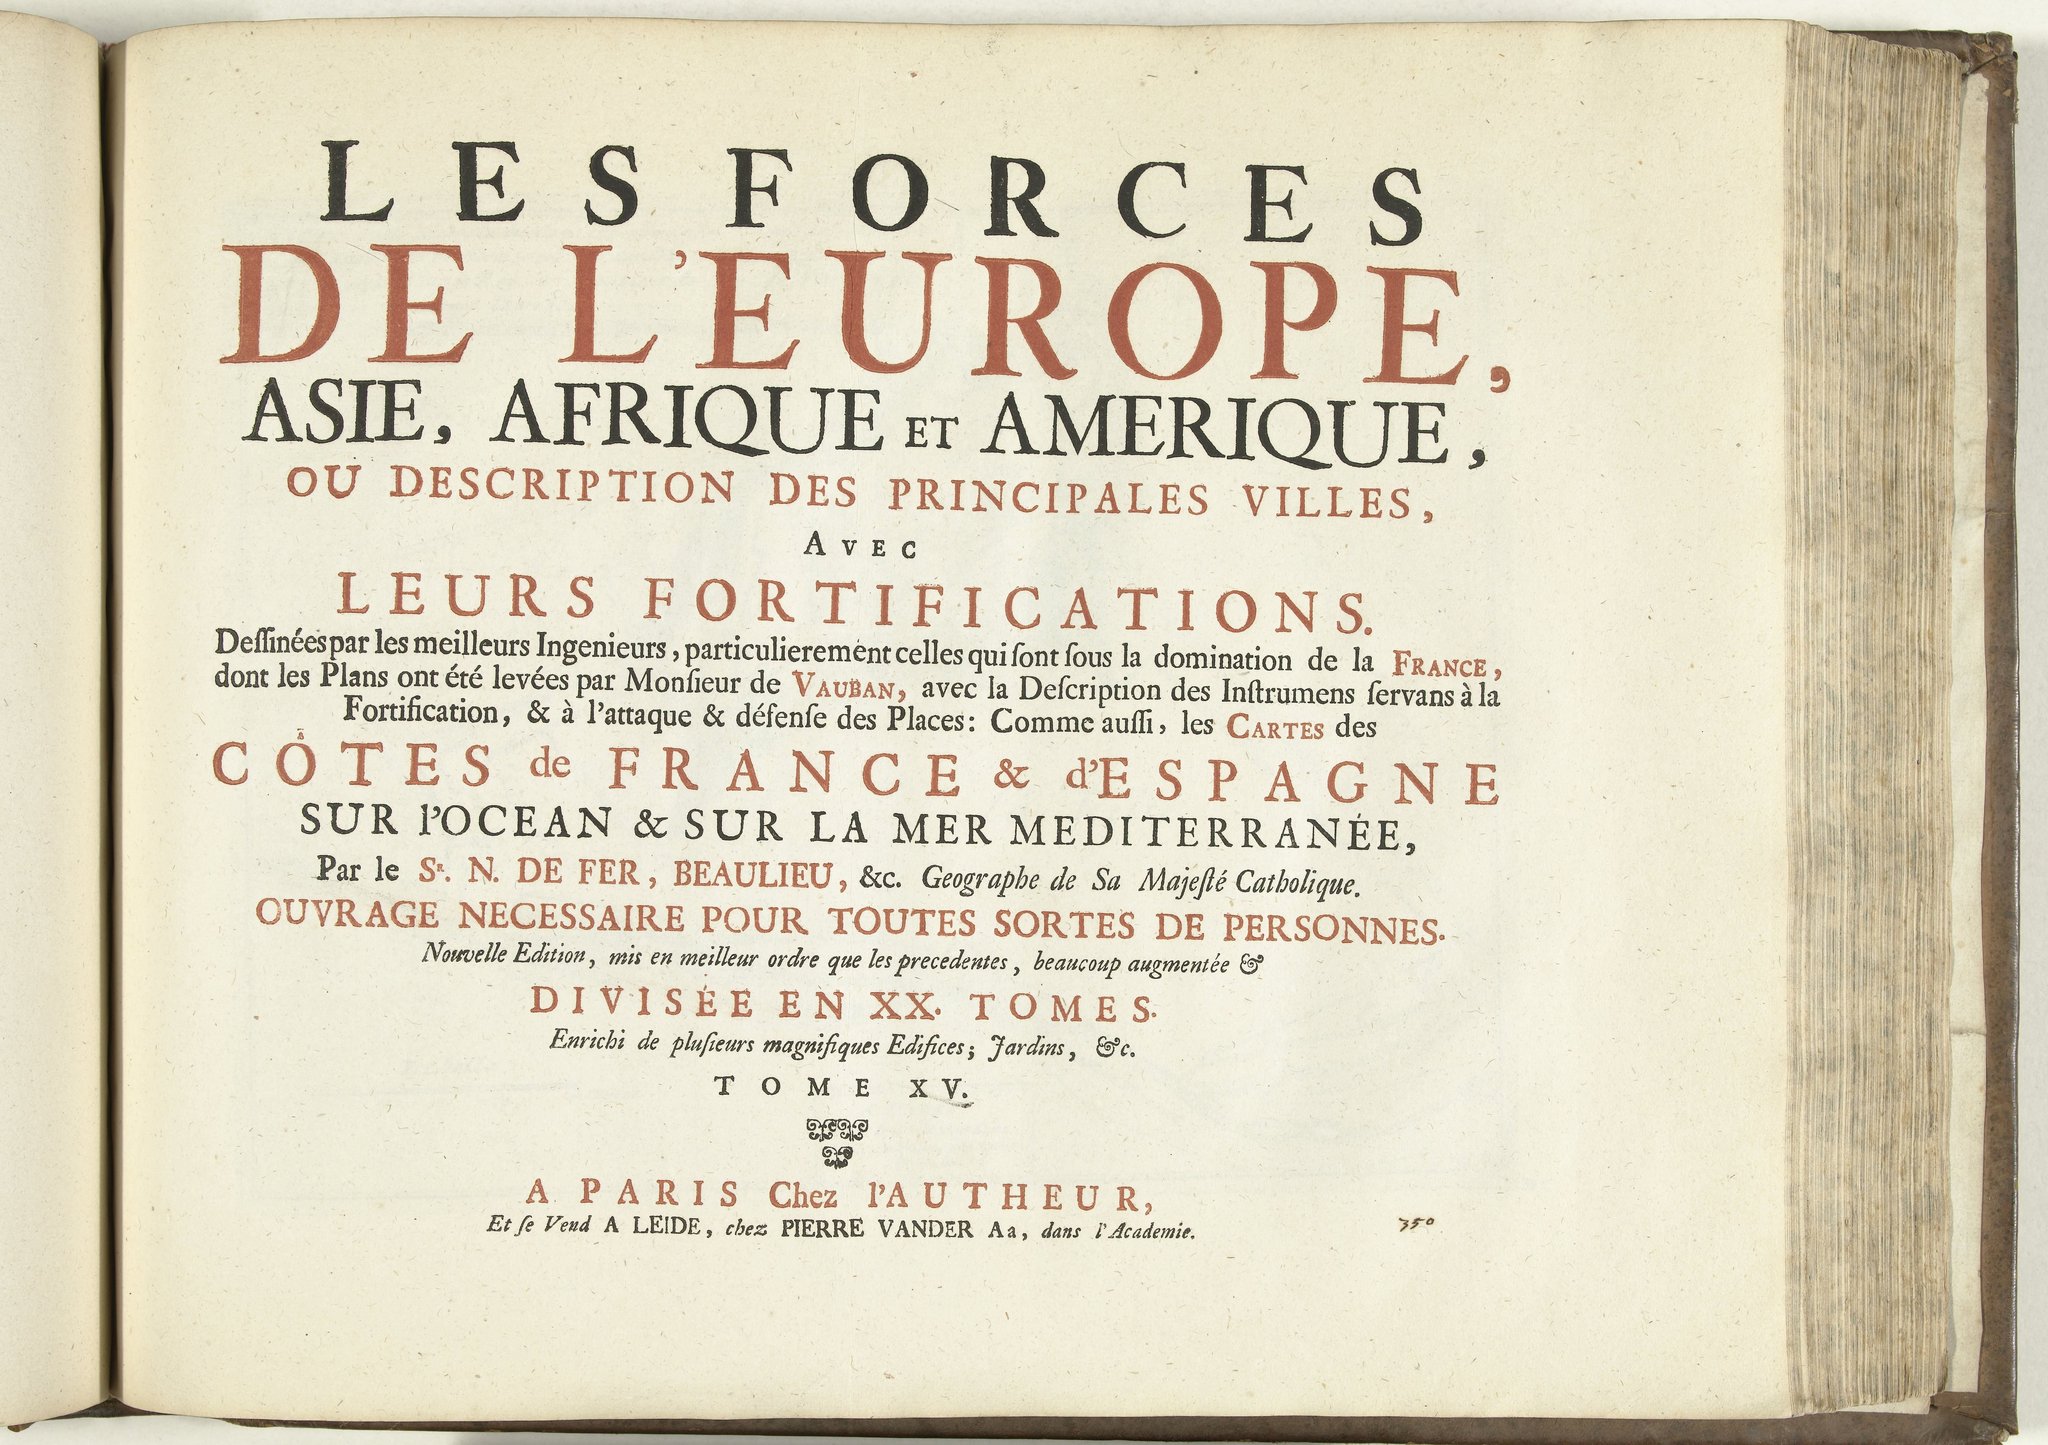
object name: titelblad, titelpagina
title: Titelpagina voor het prentwerk: Les Forces de l'Europe, Asie, Afrique et Amerique (...) Comme aussi les Cartes des Côtes de France et d'Espagne (deel XV), 1726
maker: pieter van der aa (i)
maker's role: printer, publisher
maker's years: 1659-1733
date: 1726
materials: paper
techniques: letterpress printing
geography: leiden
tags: spaanse successieoorlog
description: Titelpagina gedrukt in zwart en rood voor deel XV van het prentwerk Les Forces de l'Europe, Asie, Afrique et Amerique ... Comme aussi les Cartes des Côtes de France et d'Espagne, 1726. Dit tweede deel van het prentwerk bestaat uit 271 met de hand genummerde platen van vermaarde sterke steden en vestingen in het kader van de Spaanse Successieoorlog 1701-1713. Voor het merendeel zijn deze platen gekopieerd naar de anonieme Franse platen van vermaarde sterke steden en vestingen: in Les forces de l'Europe en in: Le theatre de la guerre, dans les Pays-Bas, beide oorspronkelijk uitgegeven door Nicolas de Fer te Parijs (1693-1697) in het kader van de Negenjarige Oorlog. Titel in het Frans.